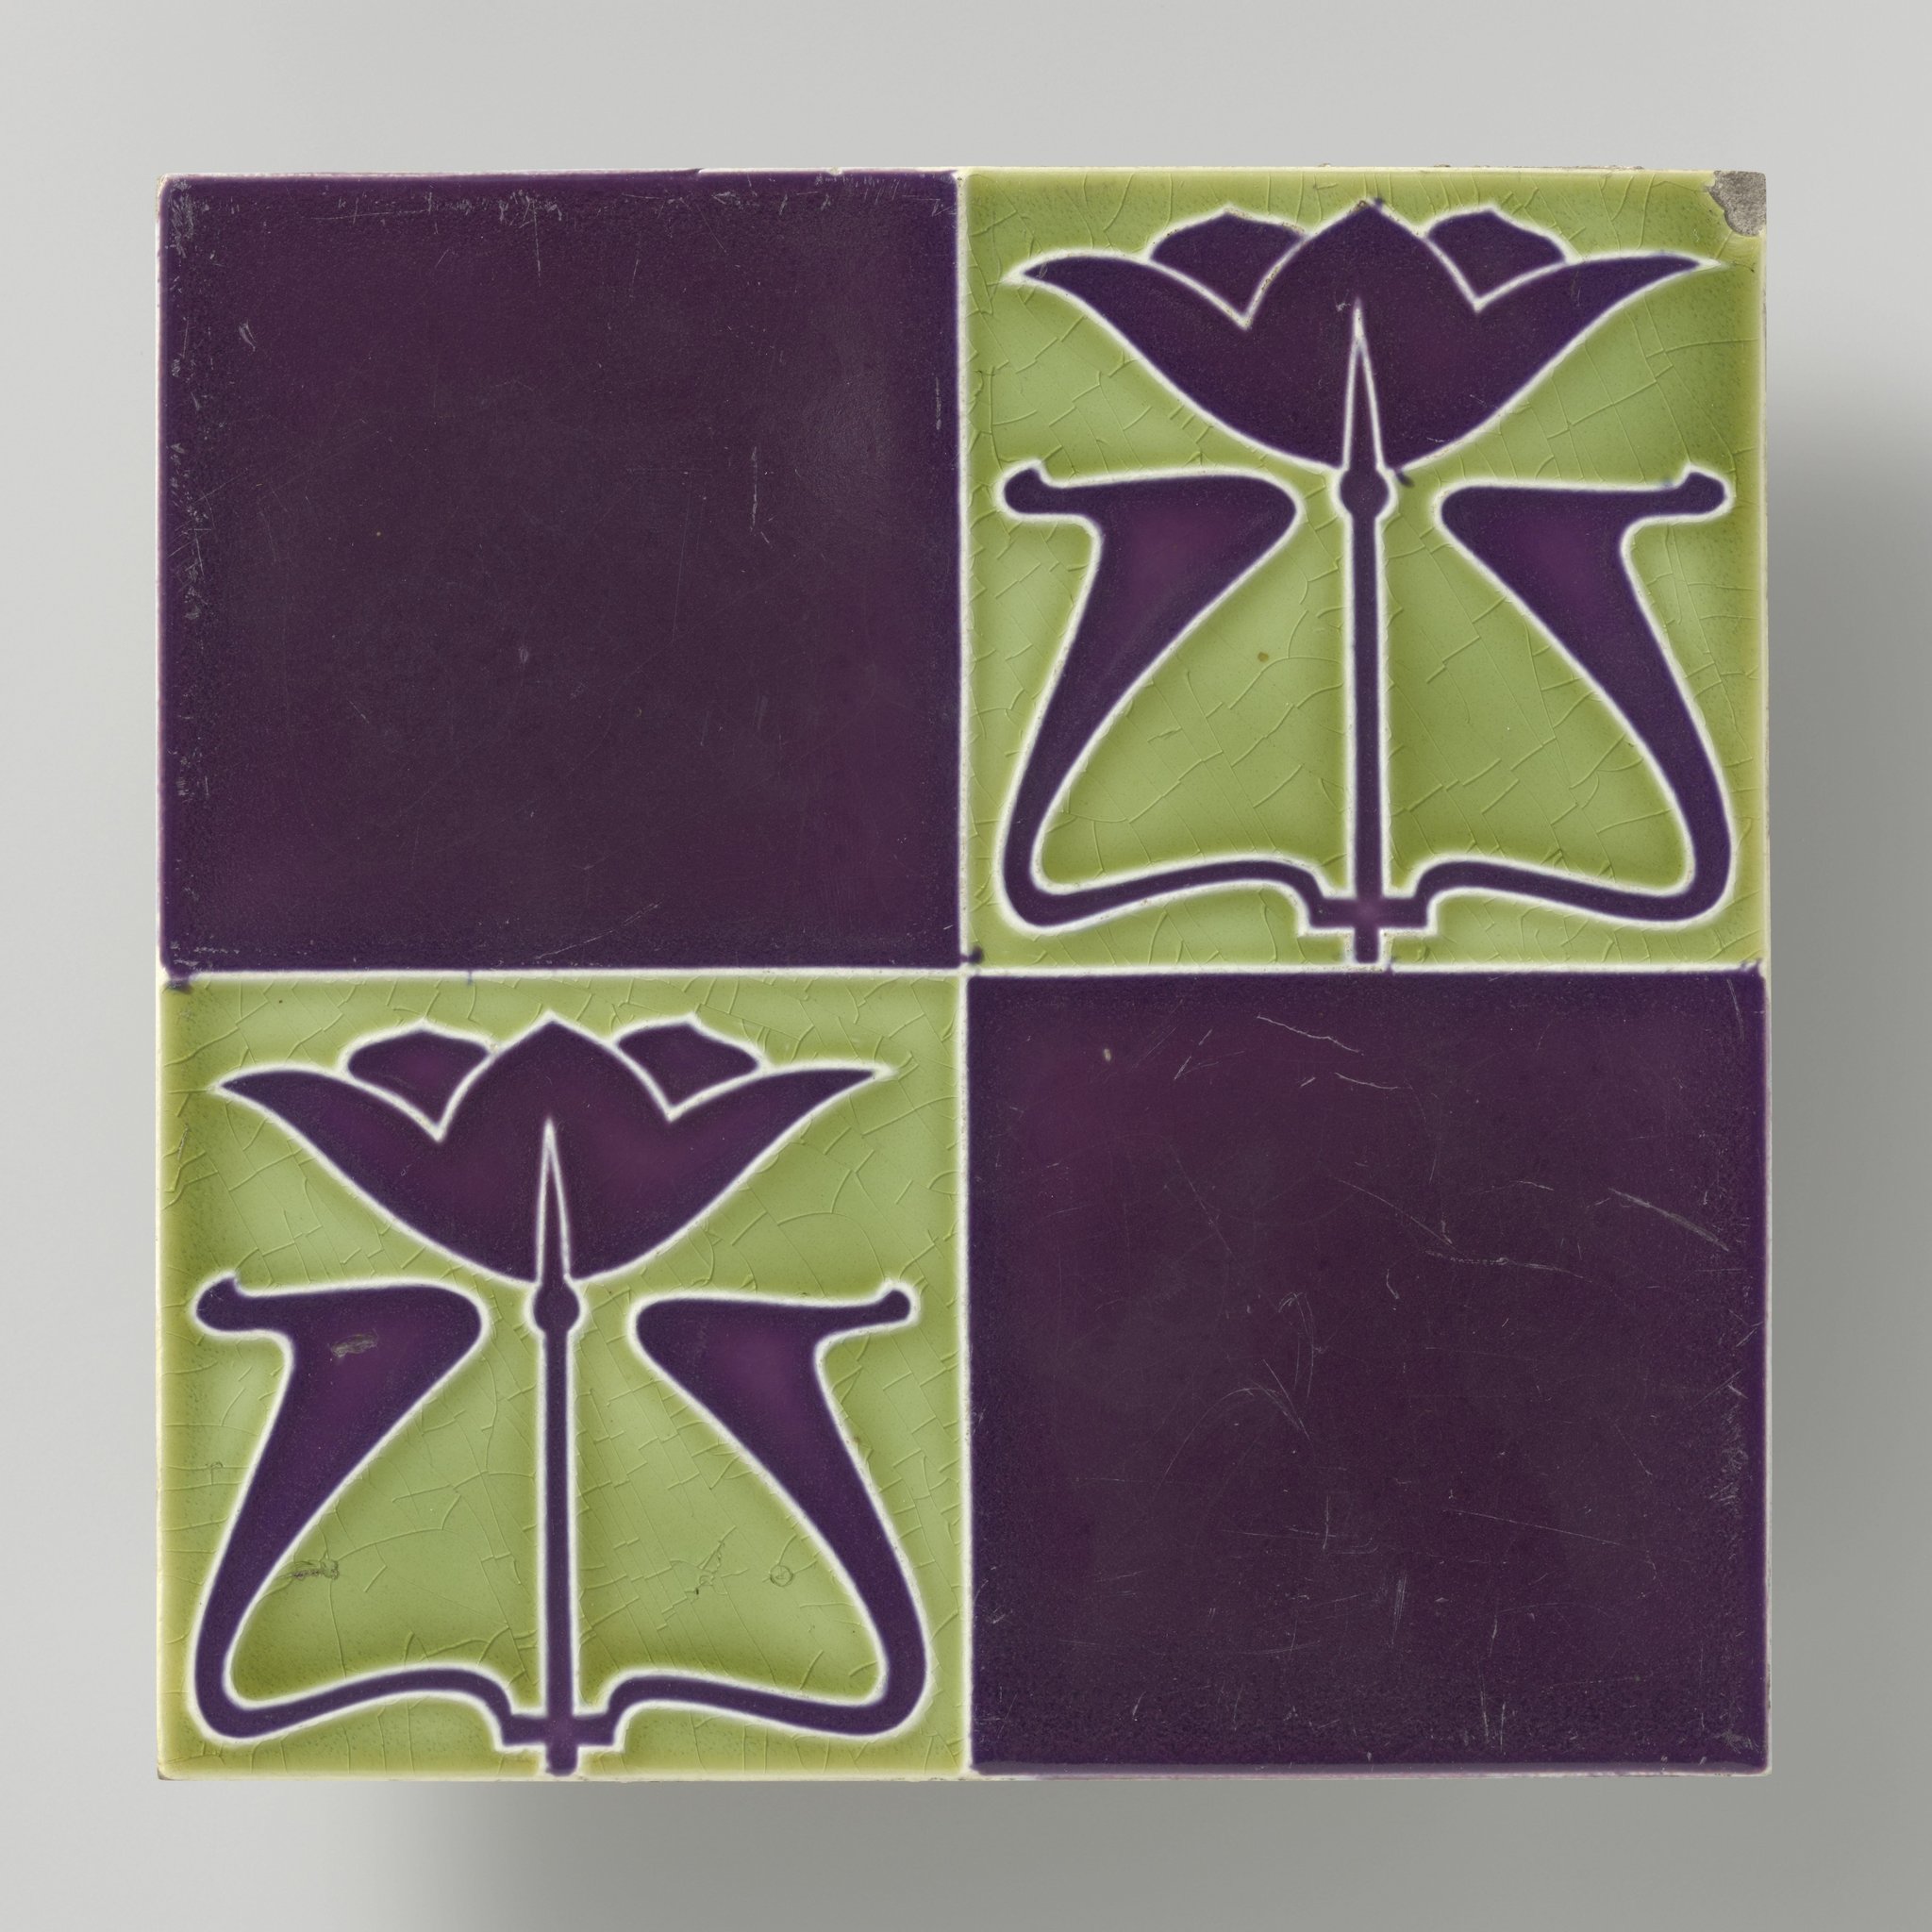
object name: tile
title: Tegel versierd in paars en groen met twee bloemkelken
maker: Anonymous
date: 1900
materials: stoneware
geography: netherlands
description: Tegel van steengoed, versierd in paars en groen met twee diagonaalsgewijs geplaatste gestileerde bloemkelken.